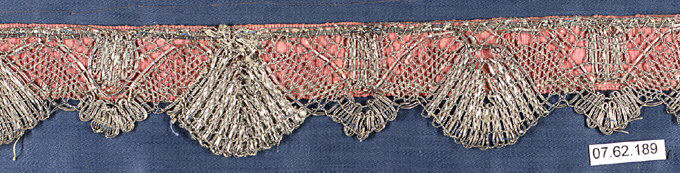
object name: strip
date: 1601-1700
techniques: lace